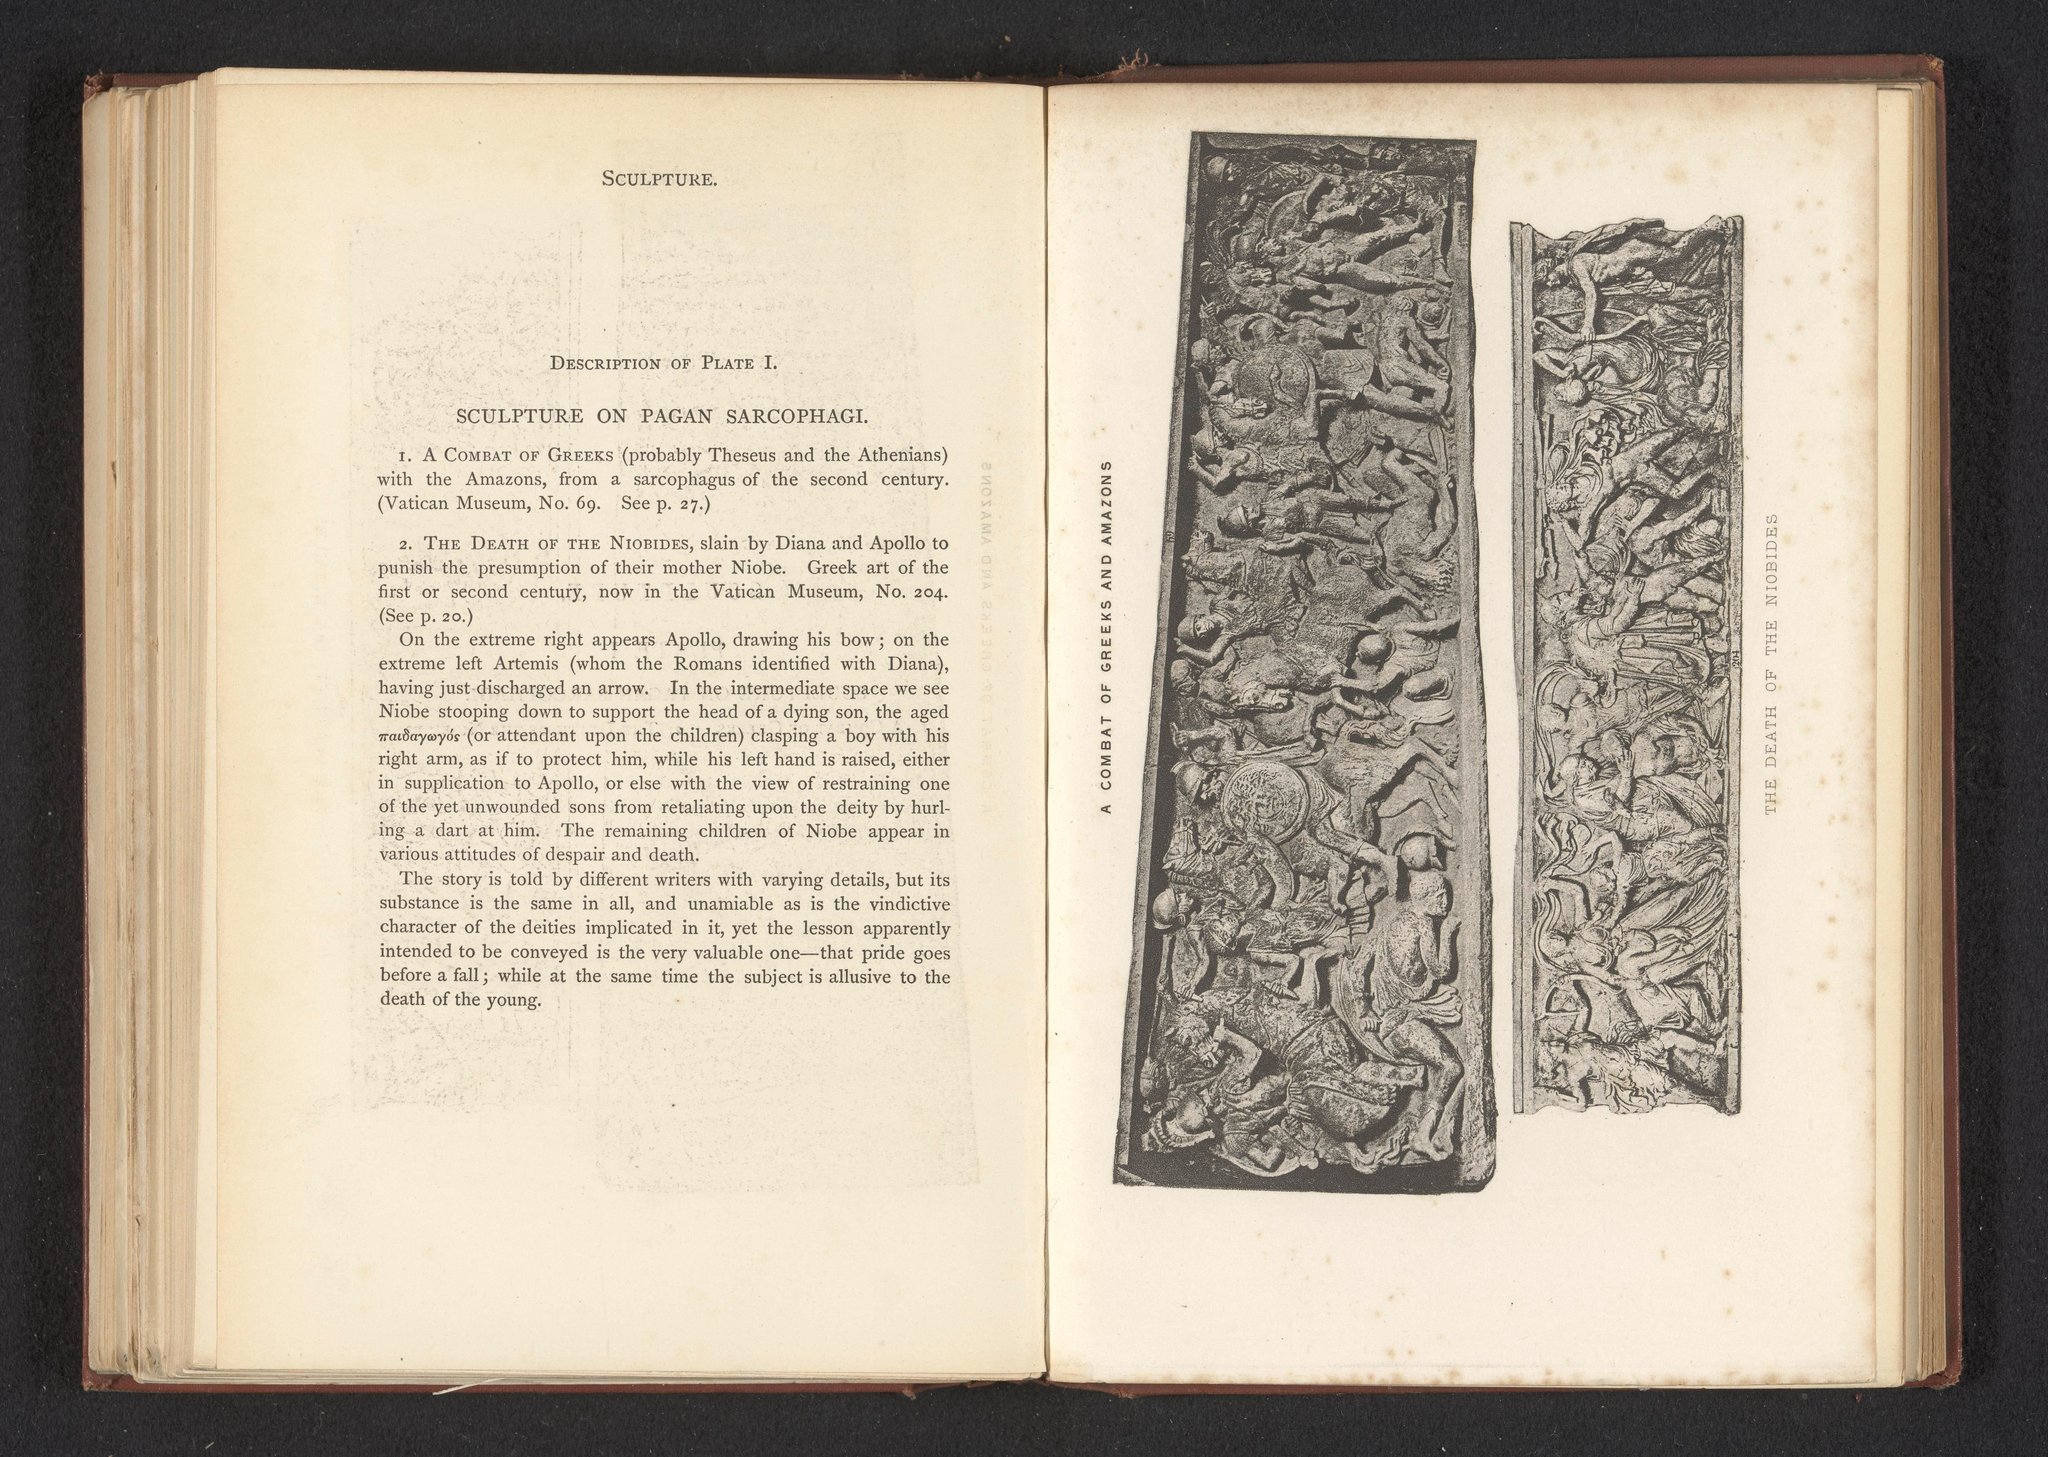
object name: page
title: A combat of Greeks and amazons The death of the niobides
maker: Anonymous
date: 1867-1877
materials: paper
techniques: photoaquatint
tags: sarcophagus, decorating 'en relief', appliquéing